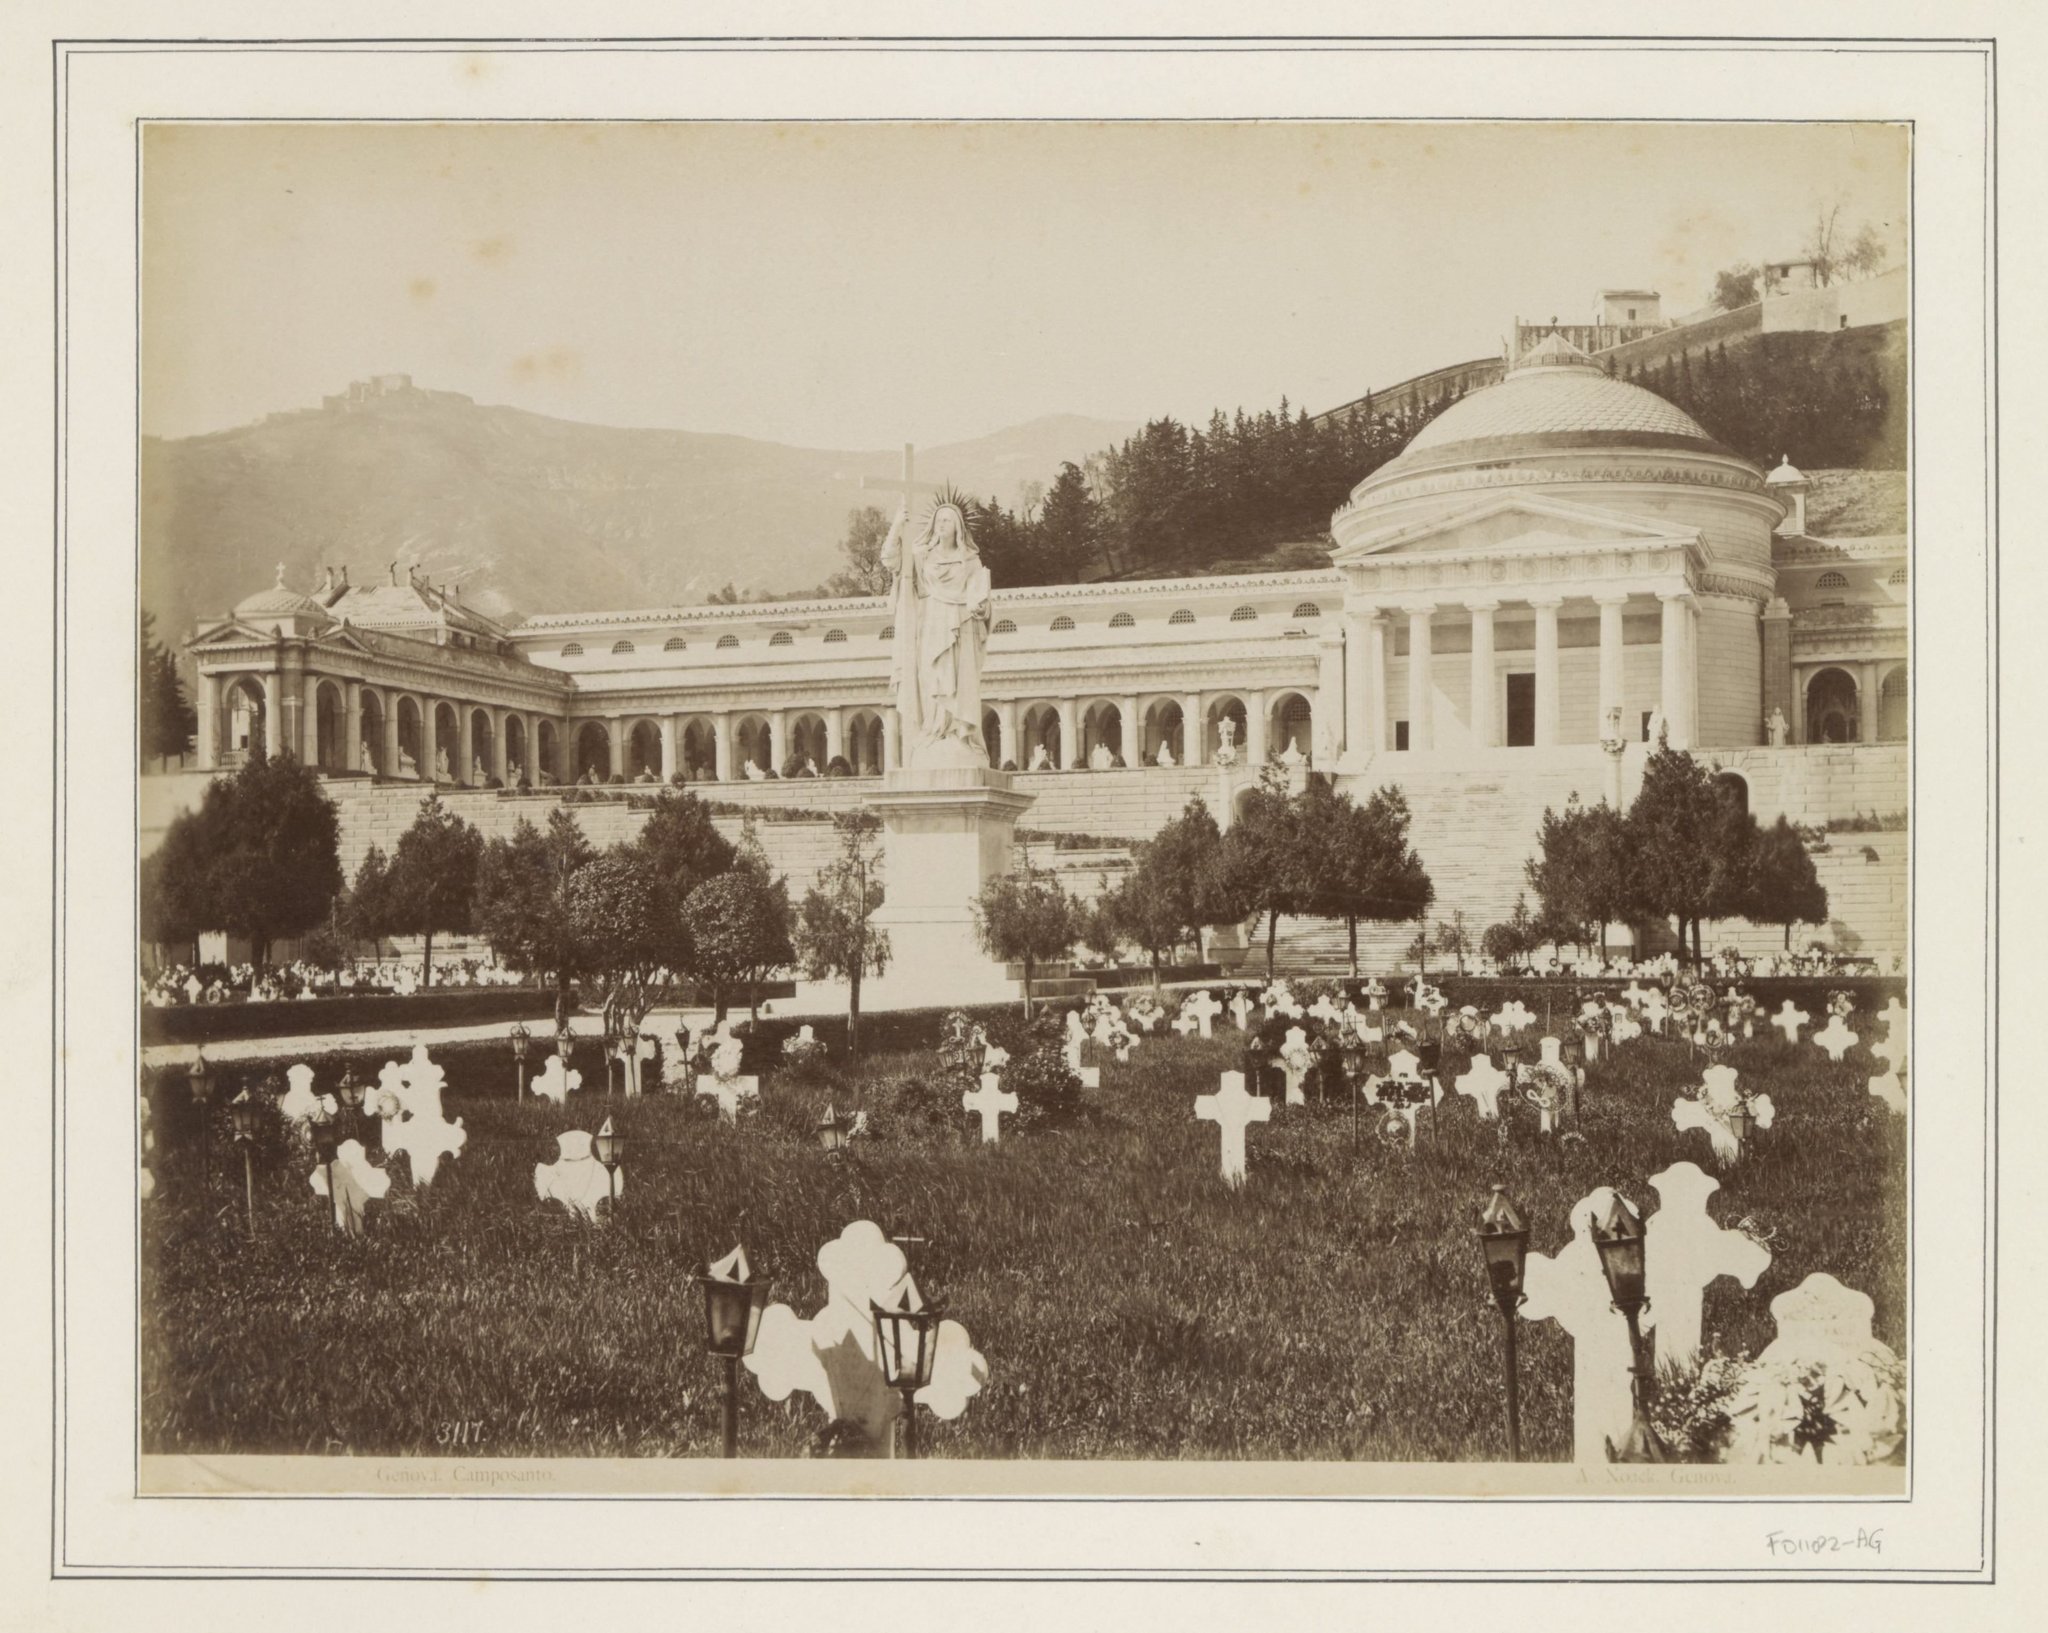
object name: photograph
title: Gezicht op de begraafplaats van Staglieno in Genua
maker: alfredo noack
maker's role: fotograaf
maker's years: 1833-1895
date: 1860-1890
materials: paper, photographic support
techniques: albumen print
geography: genoa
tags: churchyard, cemetery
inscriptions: negative number: ‘3117’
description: Onderdeel van Reisalbum met foto's van bezienswaardigheden in Italië en aan de Franse Rivièra (deel II).